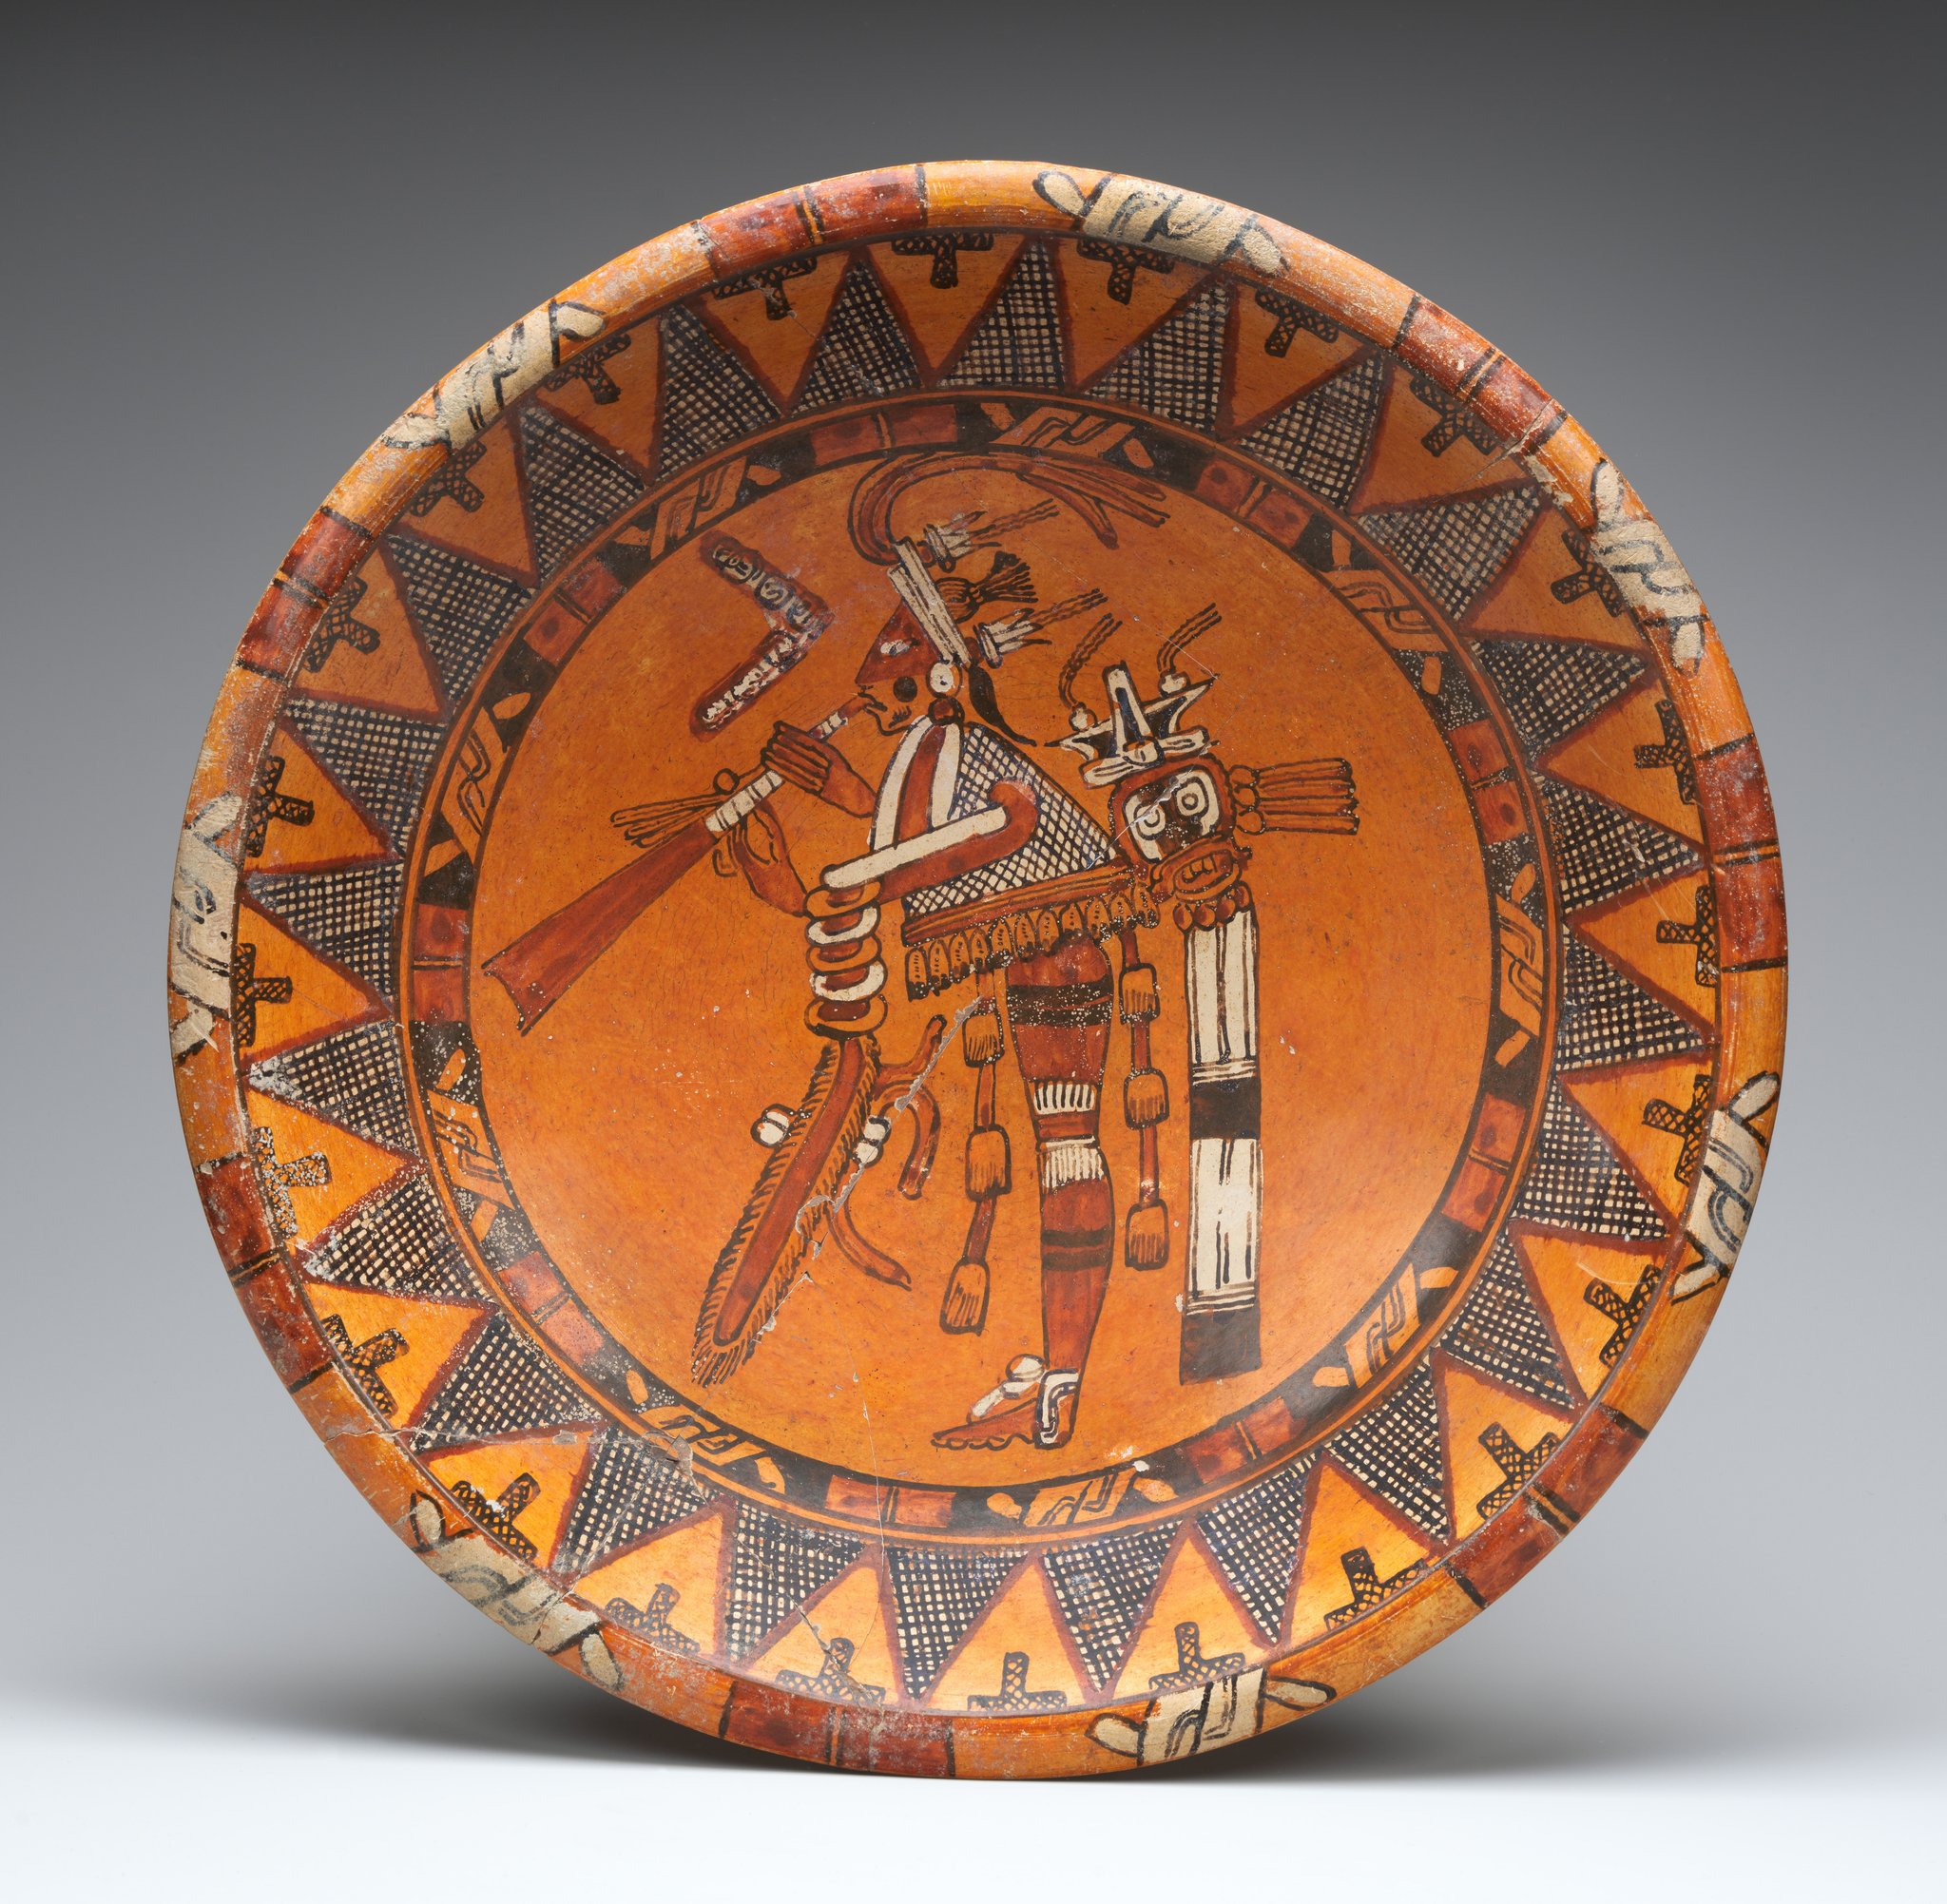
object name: plate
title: Plate with trumpeter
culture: maya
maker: maya artist(s)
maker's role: artist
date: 700-800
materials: ceramic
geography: guatemala or mexico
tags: men,trumpets,musicians